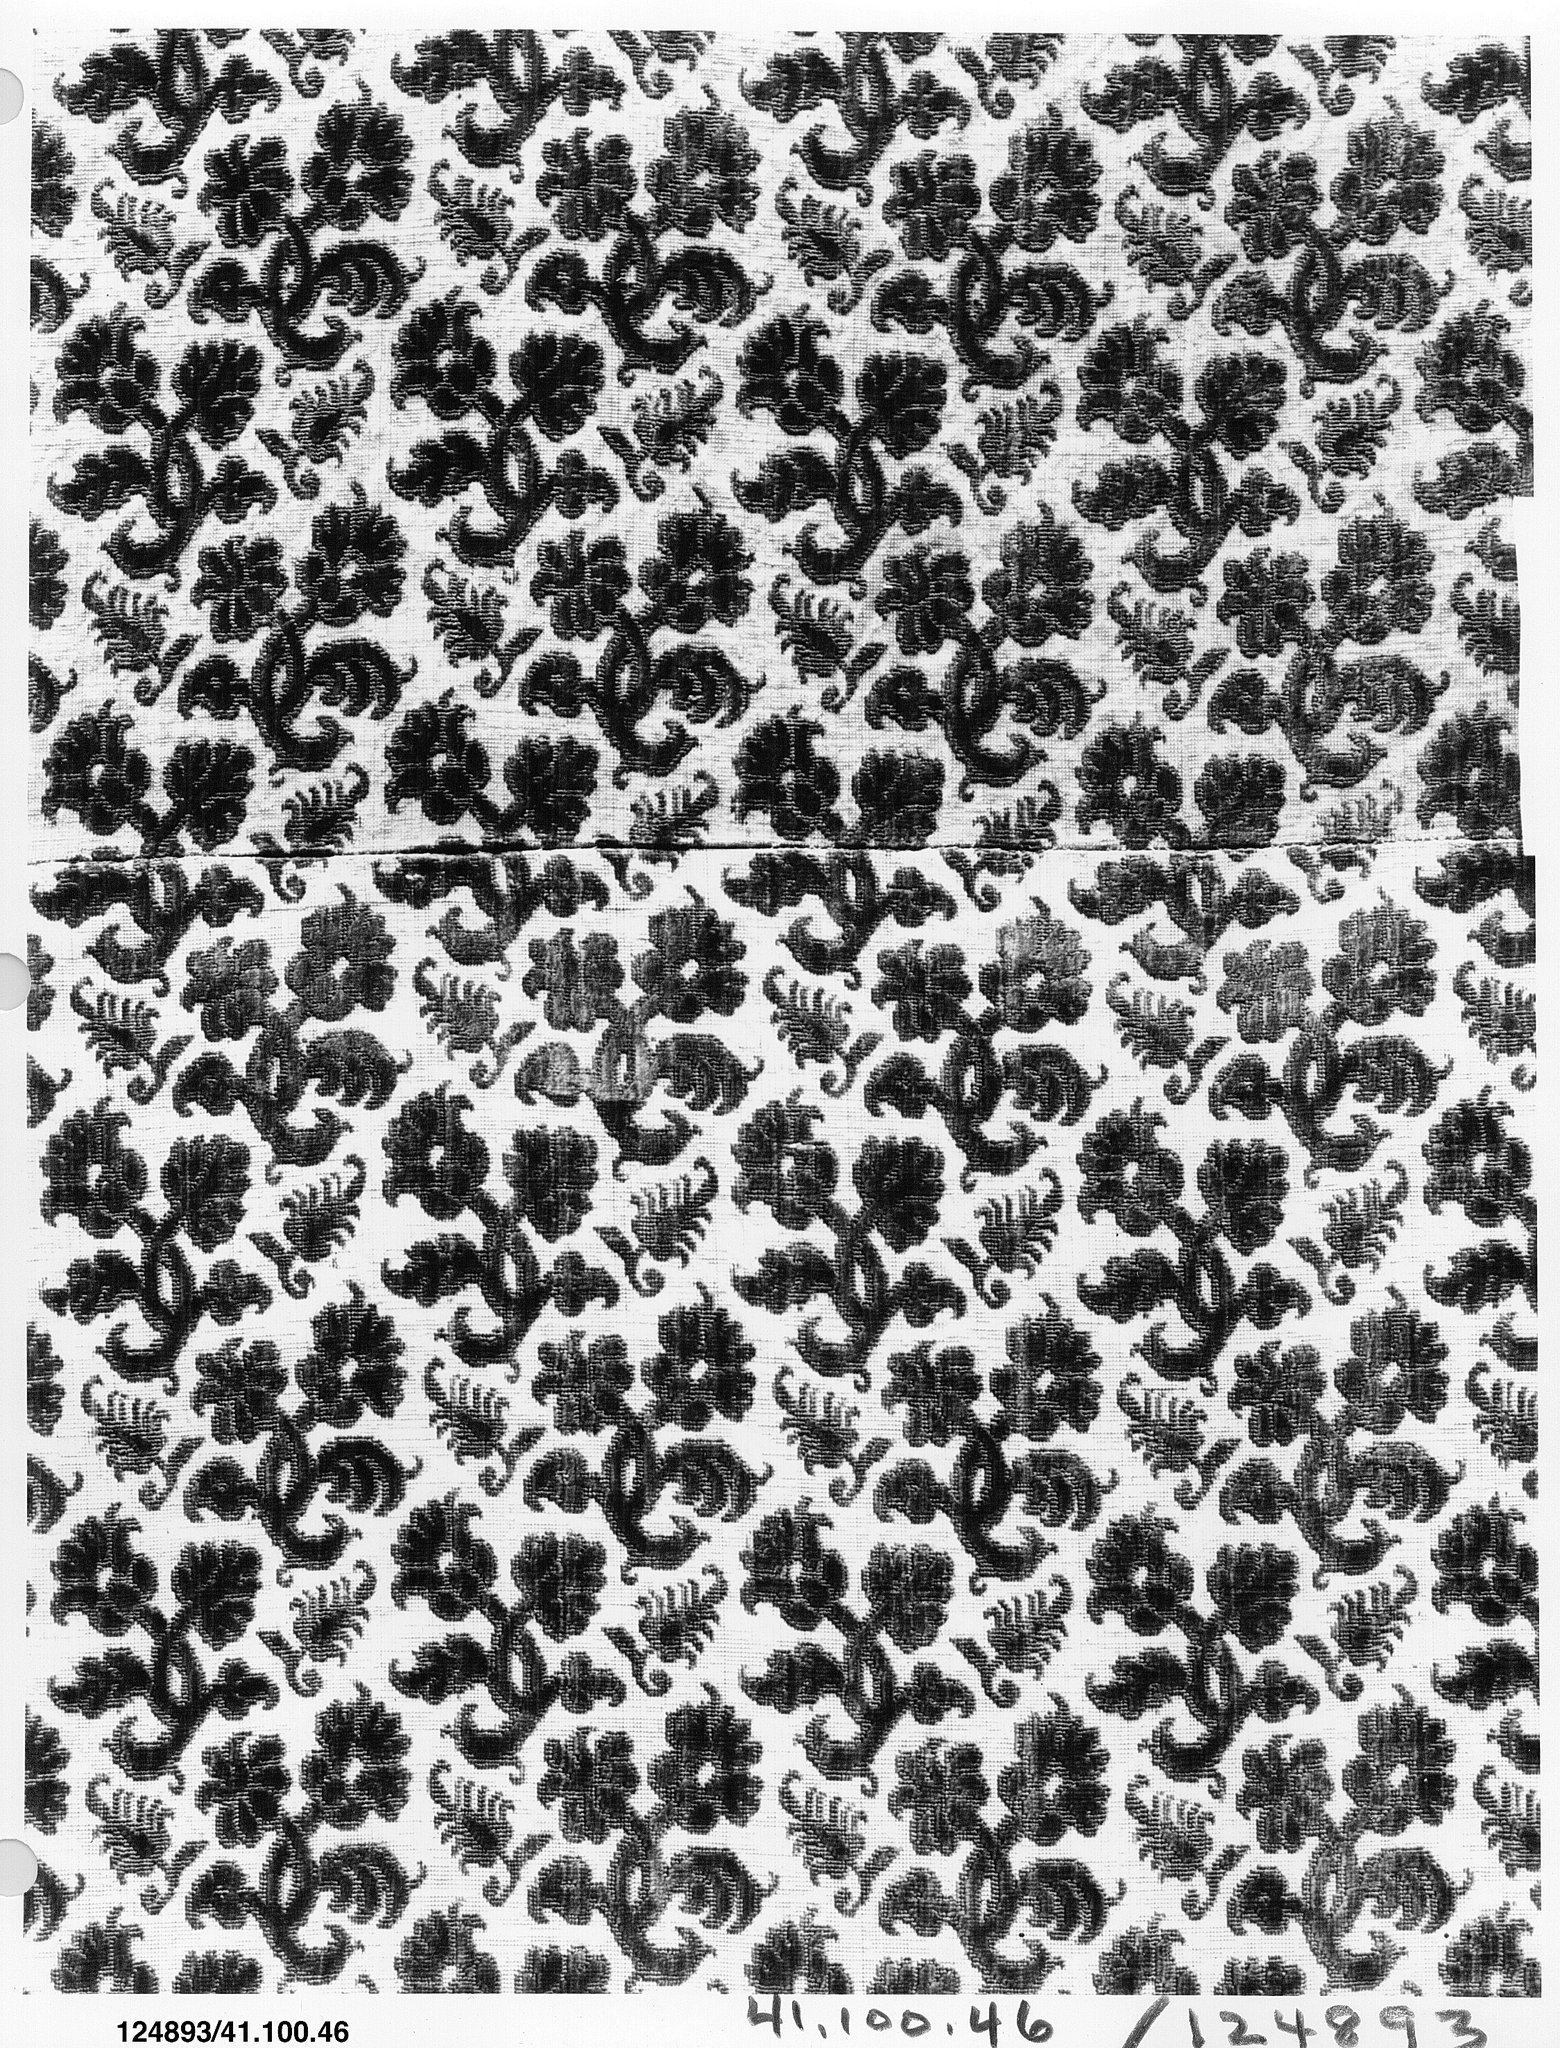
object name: runner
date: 1501-1700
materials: silk, thread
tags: flowers